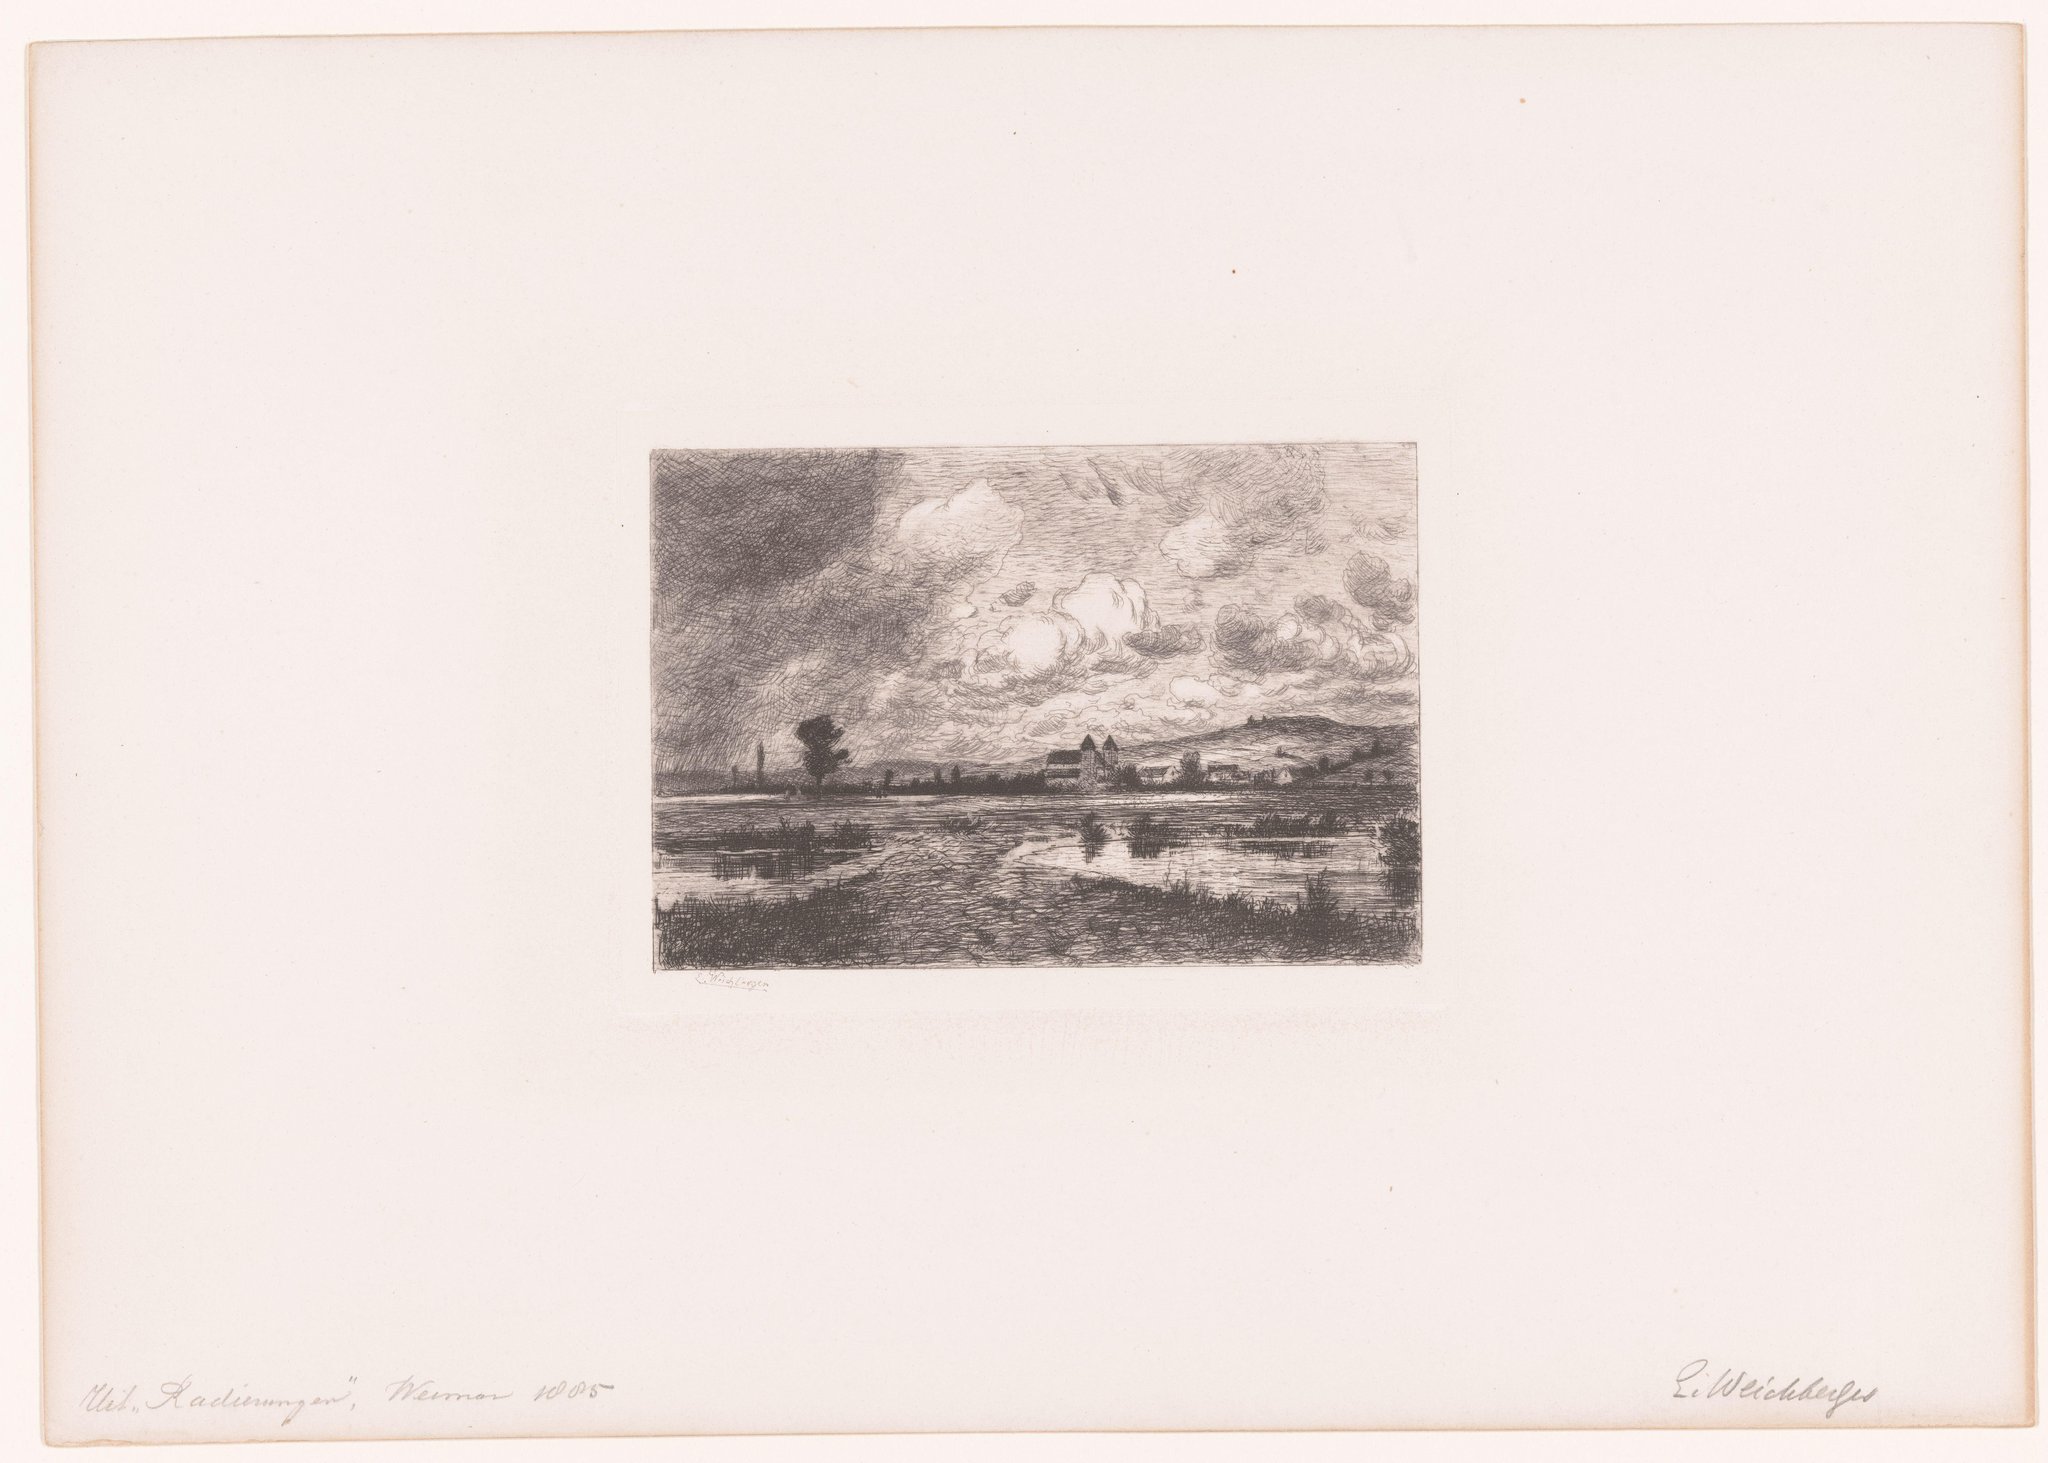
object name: print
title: Landschap met vijvers en een kerk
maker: eduard weichberger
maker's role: print maker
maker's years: 1843-1913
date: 1885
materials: paper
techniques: etching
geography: weimar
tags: city-view, and landscape with man-made constructions, pond, pool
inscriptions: inscription: ‘Uit "Radierungen", Weimar 1885’, collector's mark: Lugt 2228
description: Prent maakt deel uit van een groep prenten die tussen 1880 en 1888 werd uitgegeven door het Gesellschaft für Radierkunst te Weimar.